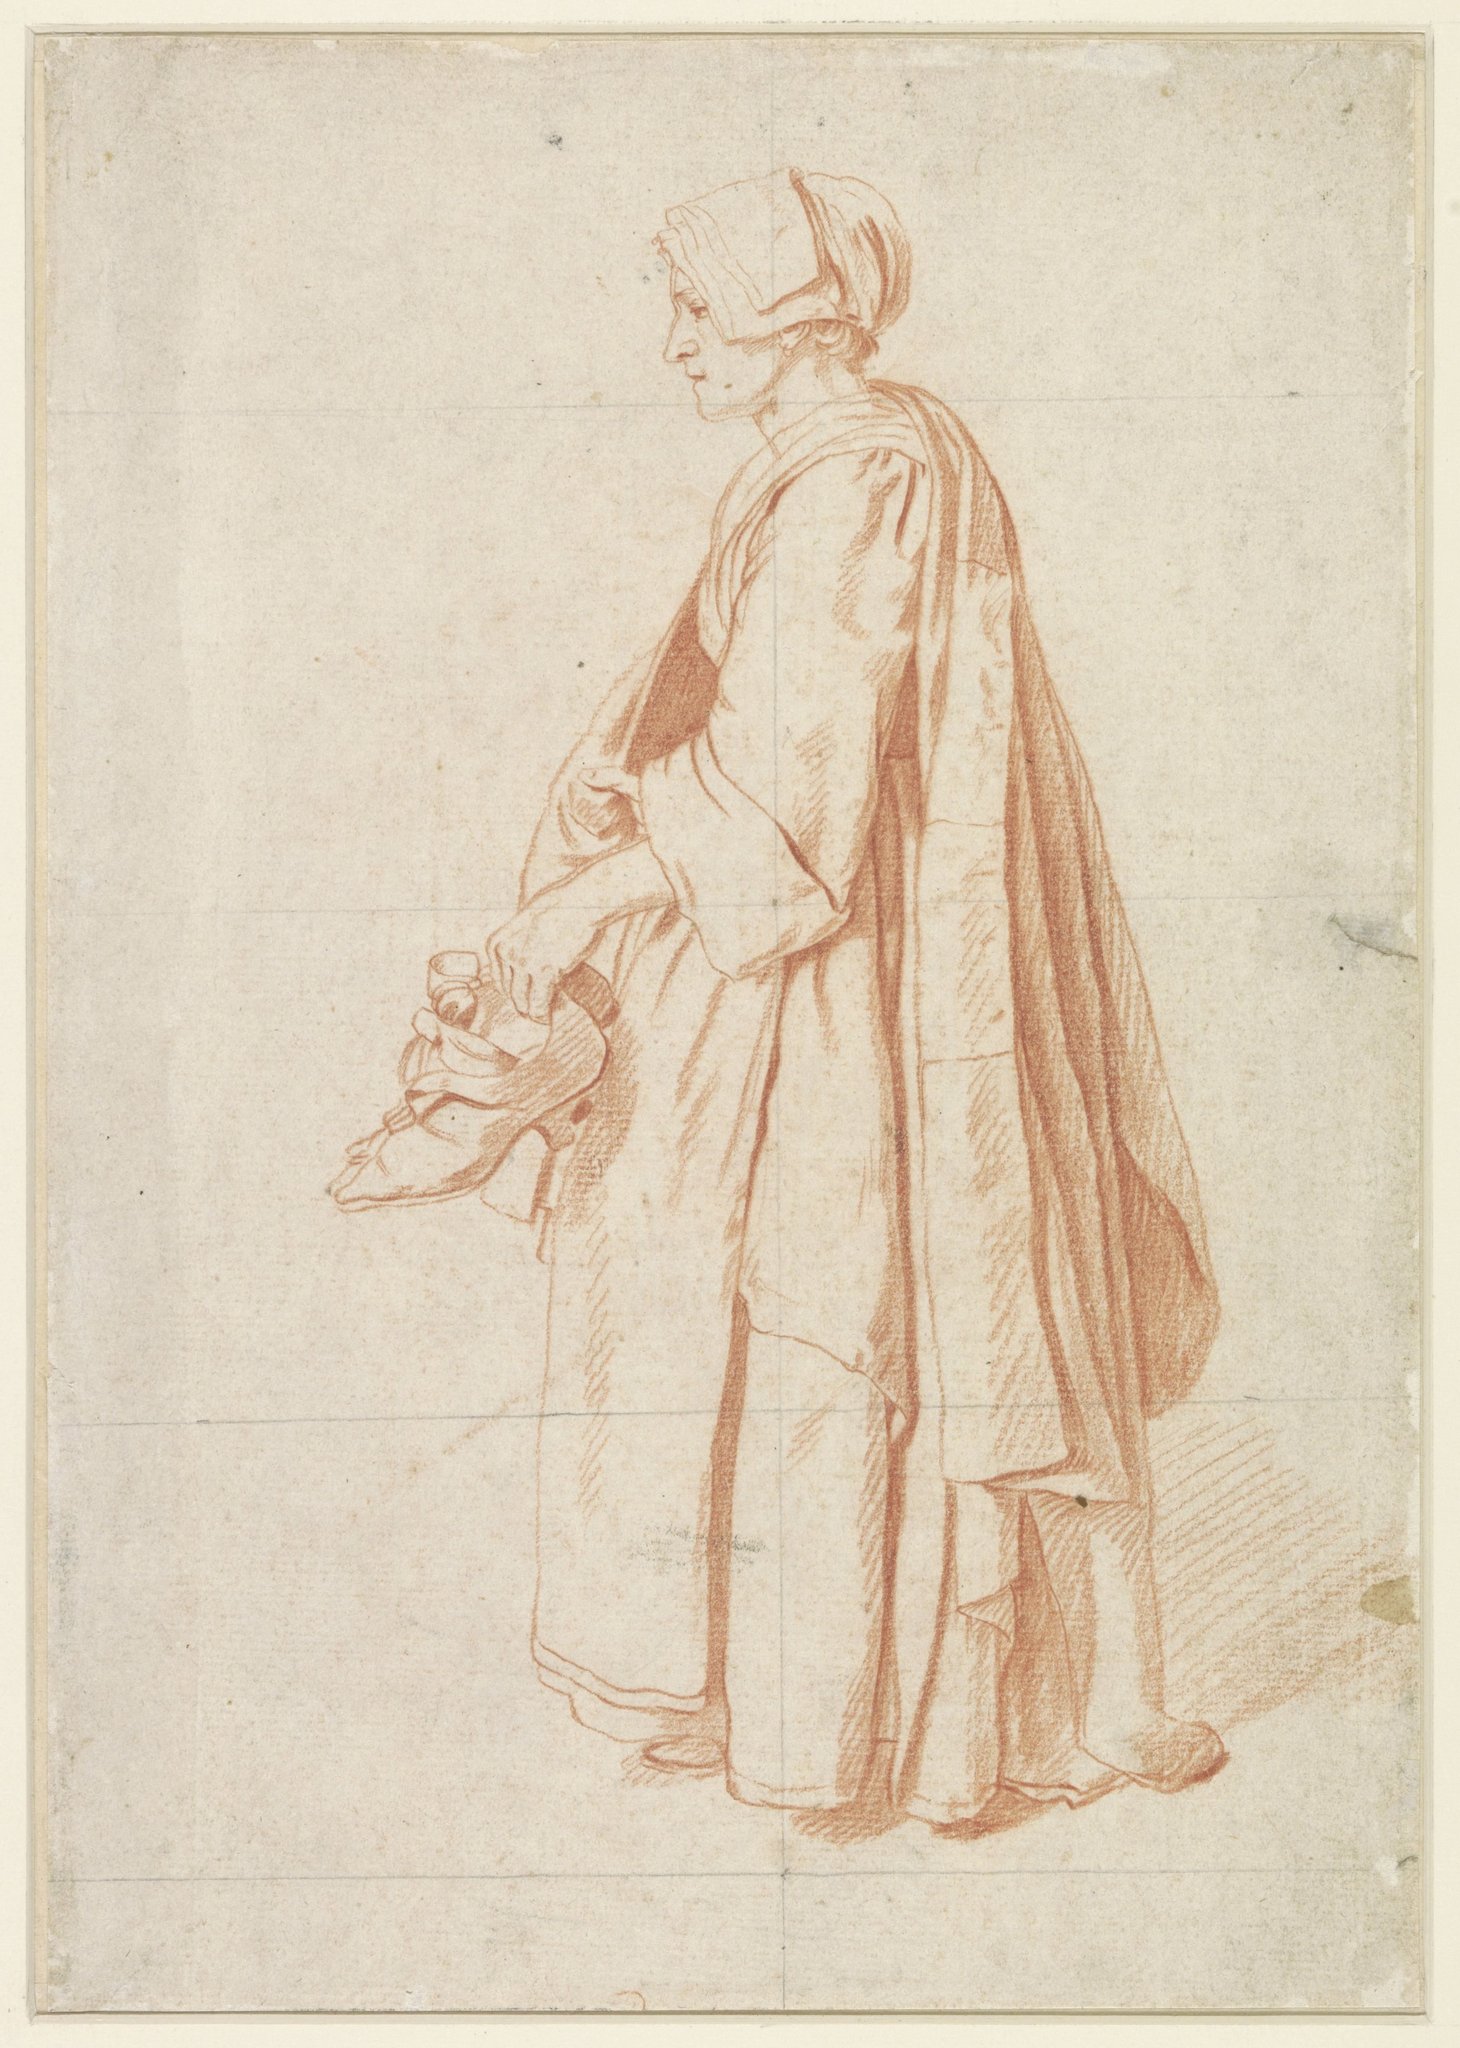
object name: drawing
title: Staande vrouw in lange mantel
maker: jan josef horemans (ii)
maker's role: draughtsman, painter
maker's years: 1714-1790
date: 1724-1790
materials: chalk, paper, pencil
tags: shoes, sandals (+ women's clothes), standing figure - aa - female human figure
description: Staande vrouw in lange mantel met een paar schoenen in de linkerhand.